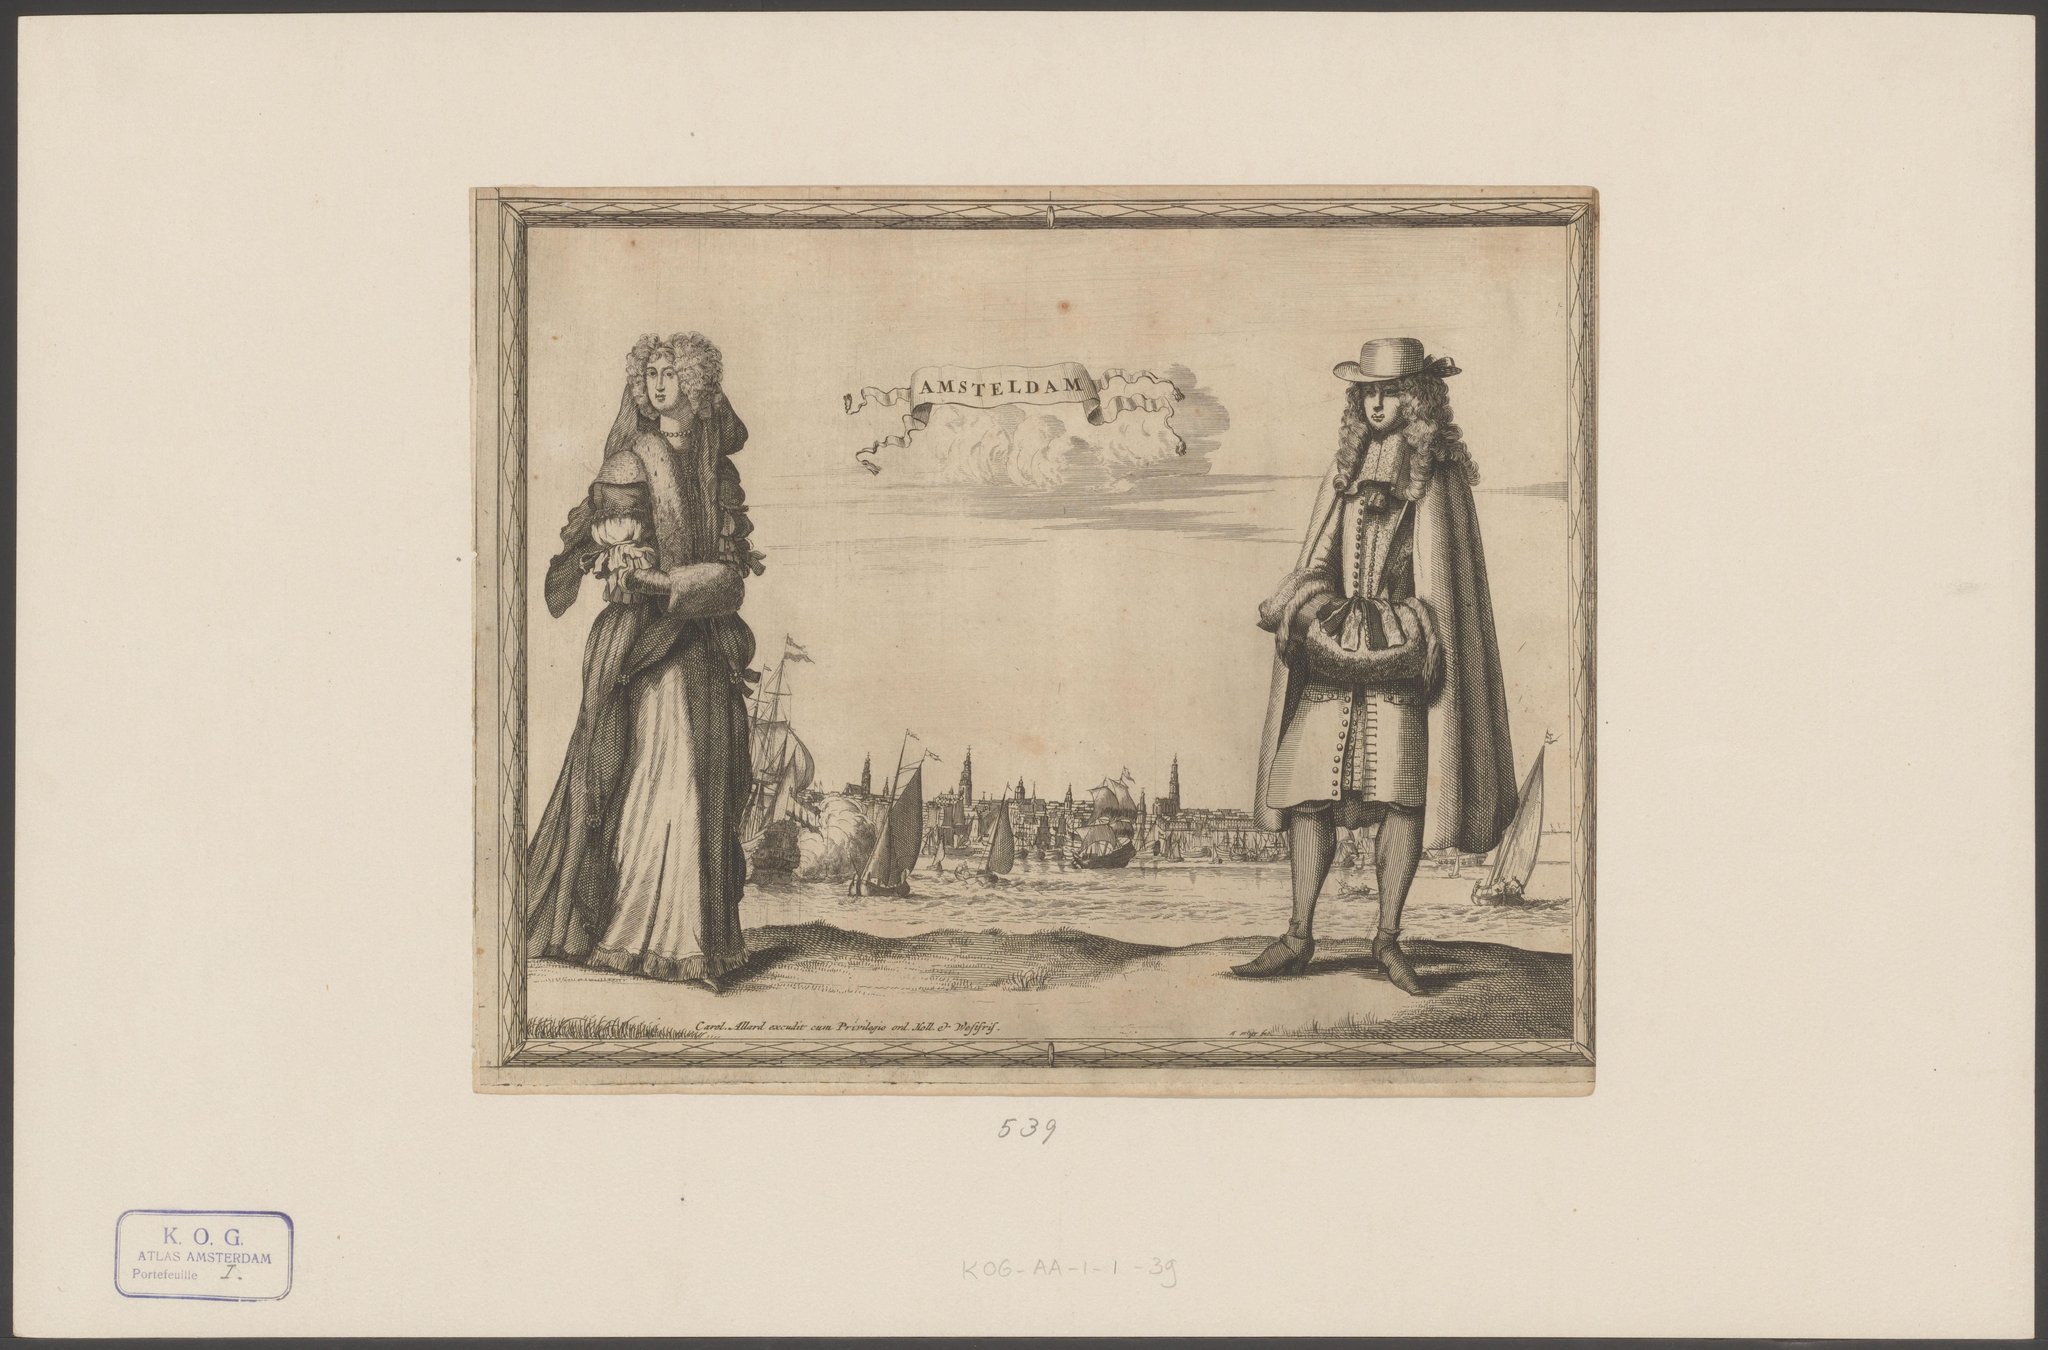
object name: print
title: Gezicht op de stad Amsterdam vanaf het IJ, met vrouw en man gekleed volgens de destijdse mode van Amsterdam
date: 1683-1689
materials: paper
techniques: engraving, etching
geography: amsterdam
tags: city-view in general; 'veduta', river, clothes, costume (+ women's clothes), clothes, costume (+ men's clothes), ships (in general) - cc - more than one ship, amsterdam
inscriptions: collector's mark: ‘I’ Lugt 1641b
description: Prent mogelijk uit: Allard, Carel. Orbis habitabilis oppida et vestitus. Des bewoonden waerelds steden en dragten. Amsterdam: Carel Allard, 168X.